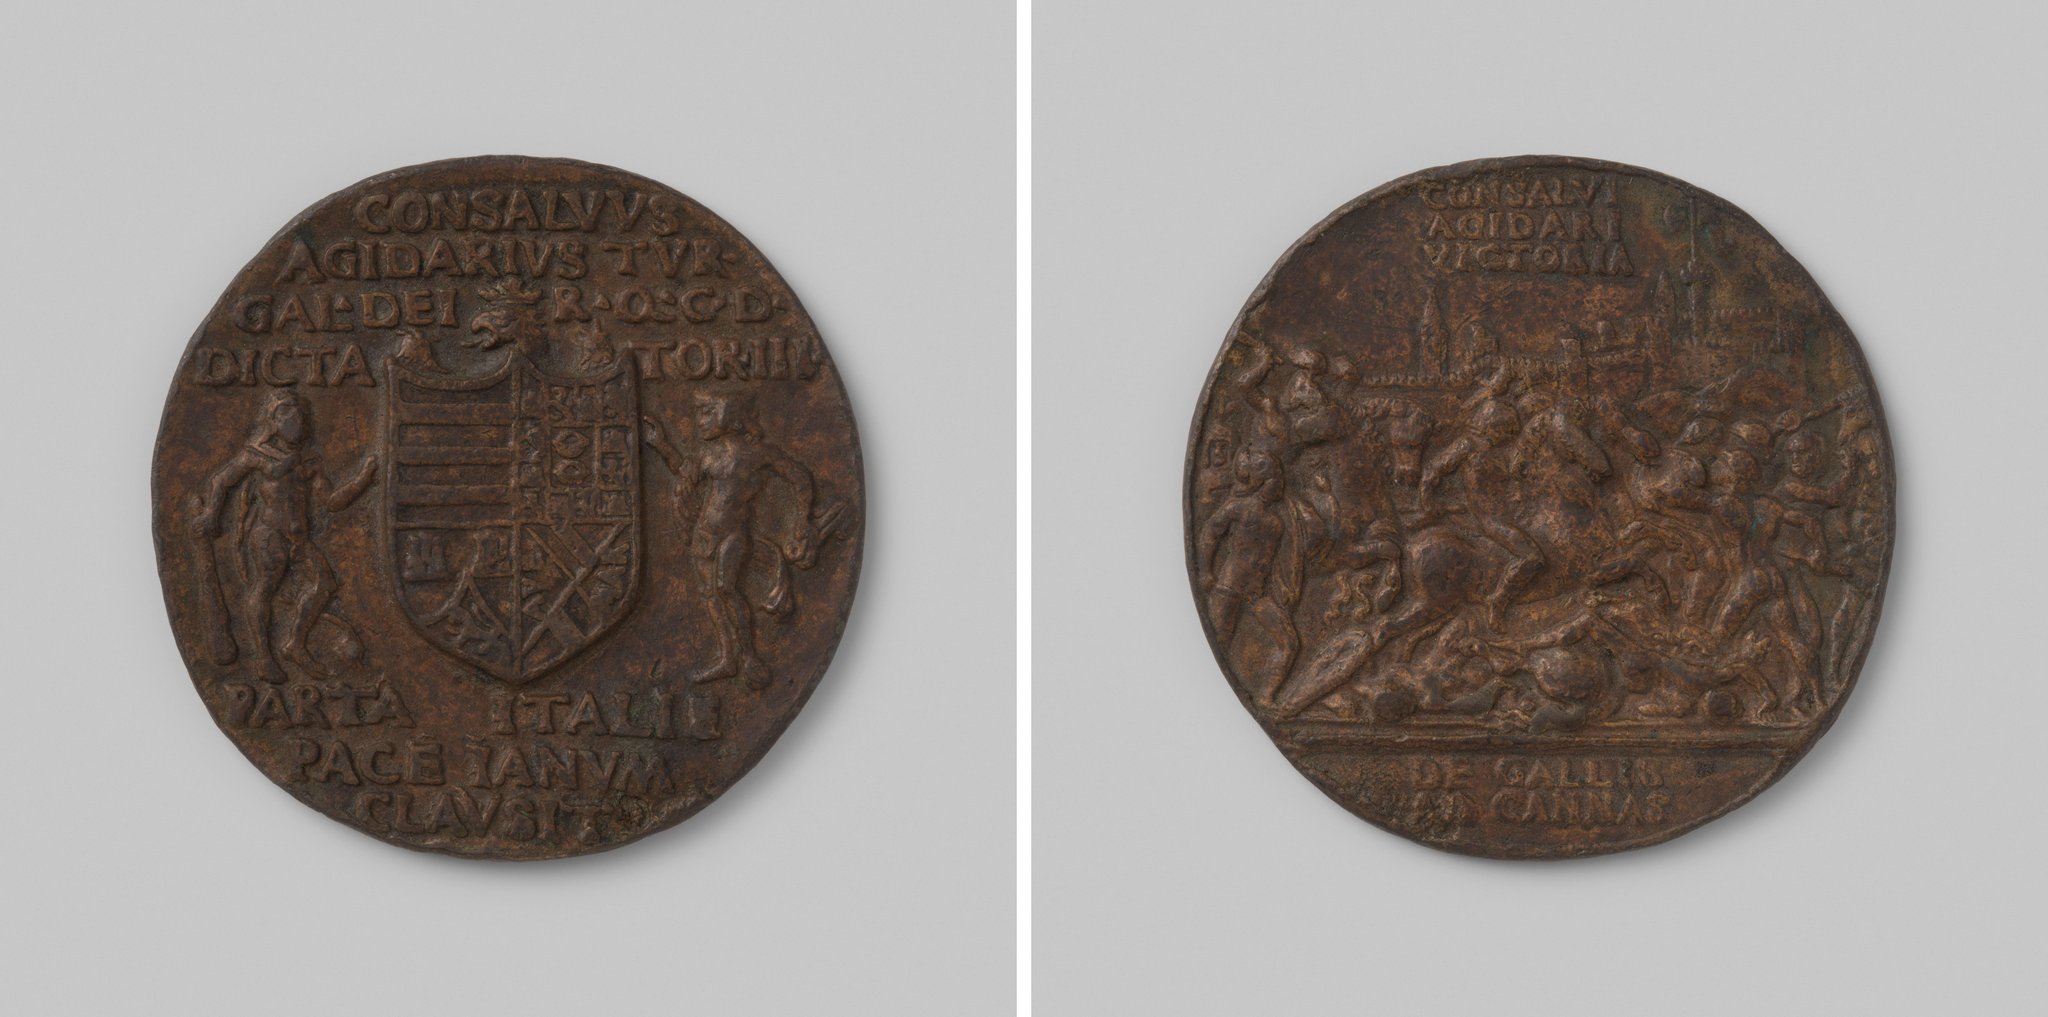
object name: copy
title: Overwinningen op de Fransen bij Cannae, in de buurt van Cerignola, ter ere van Gonzalo Fernandez de Cordoba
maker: Anonymous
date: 1503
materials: bronze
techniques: casting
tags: cerignola, canne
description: Bronzen penning. Voorzijde: Herkules met leeuwehuid en knots en Janus met sleutelbos staande naast wapenschild, bekroond met adelaarskop tussen opschriften. Keerzijde: veldslag binnen omschrift